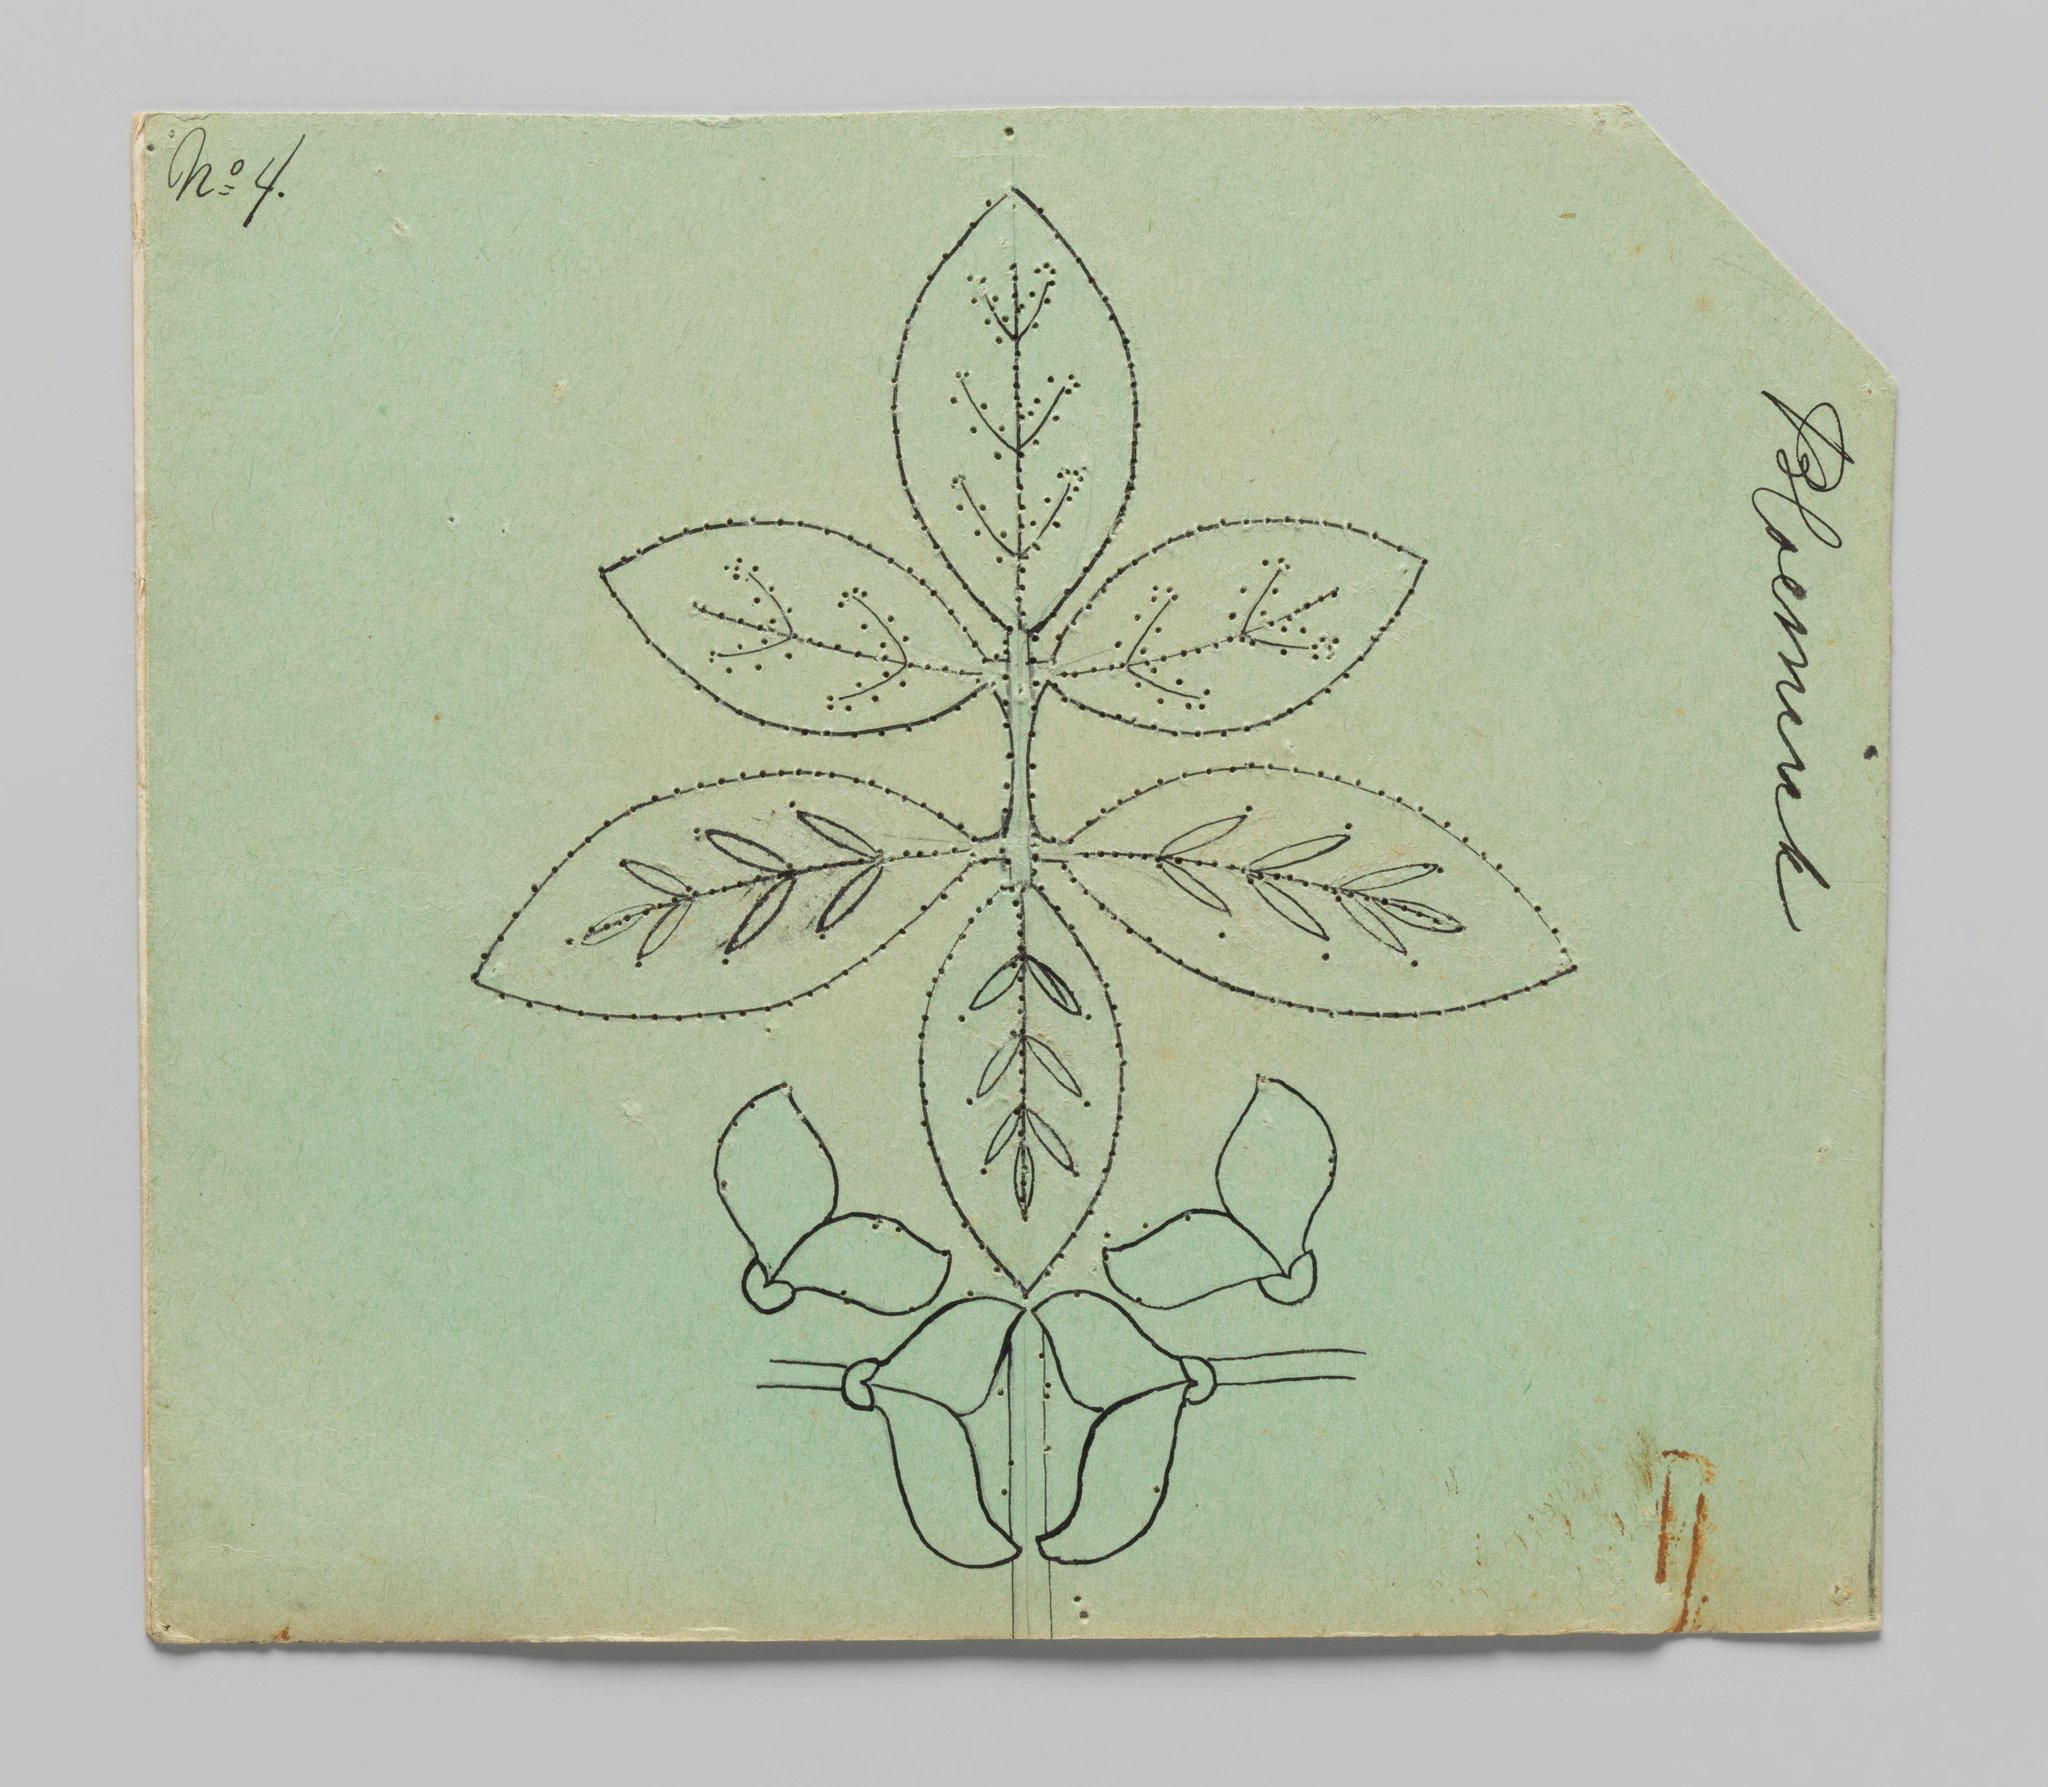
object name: tool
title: Kantpatroon voor een kleed van kloskant met goudenregentakken en -bloemen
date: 1912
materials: paper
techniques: drawing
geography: apeldoorn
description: Kantbrief of kantpatroon met een deel van het patroon voor een kleed met invnr. BK-1979-84. De brief is genummerd (4) en op de voorkant is de naam Bloemink geschreven.